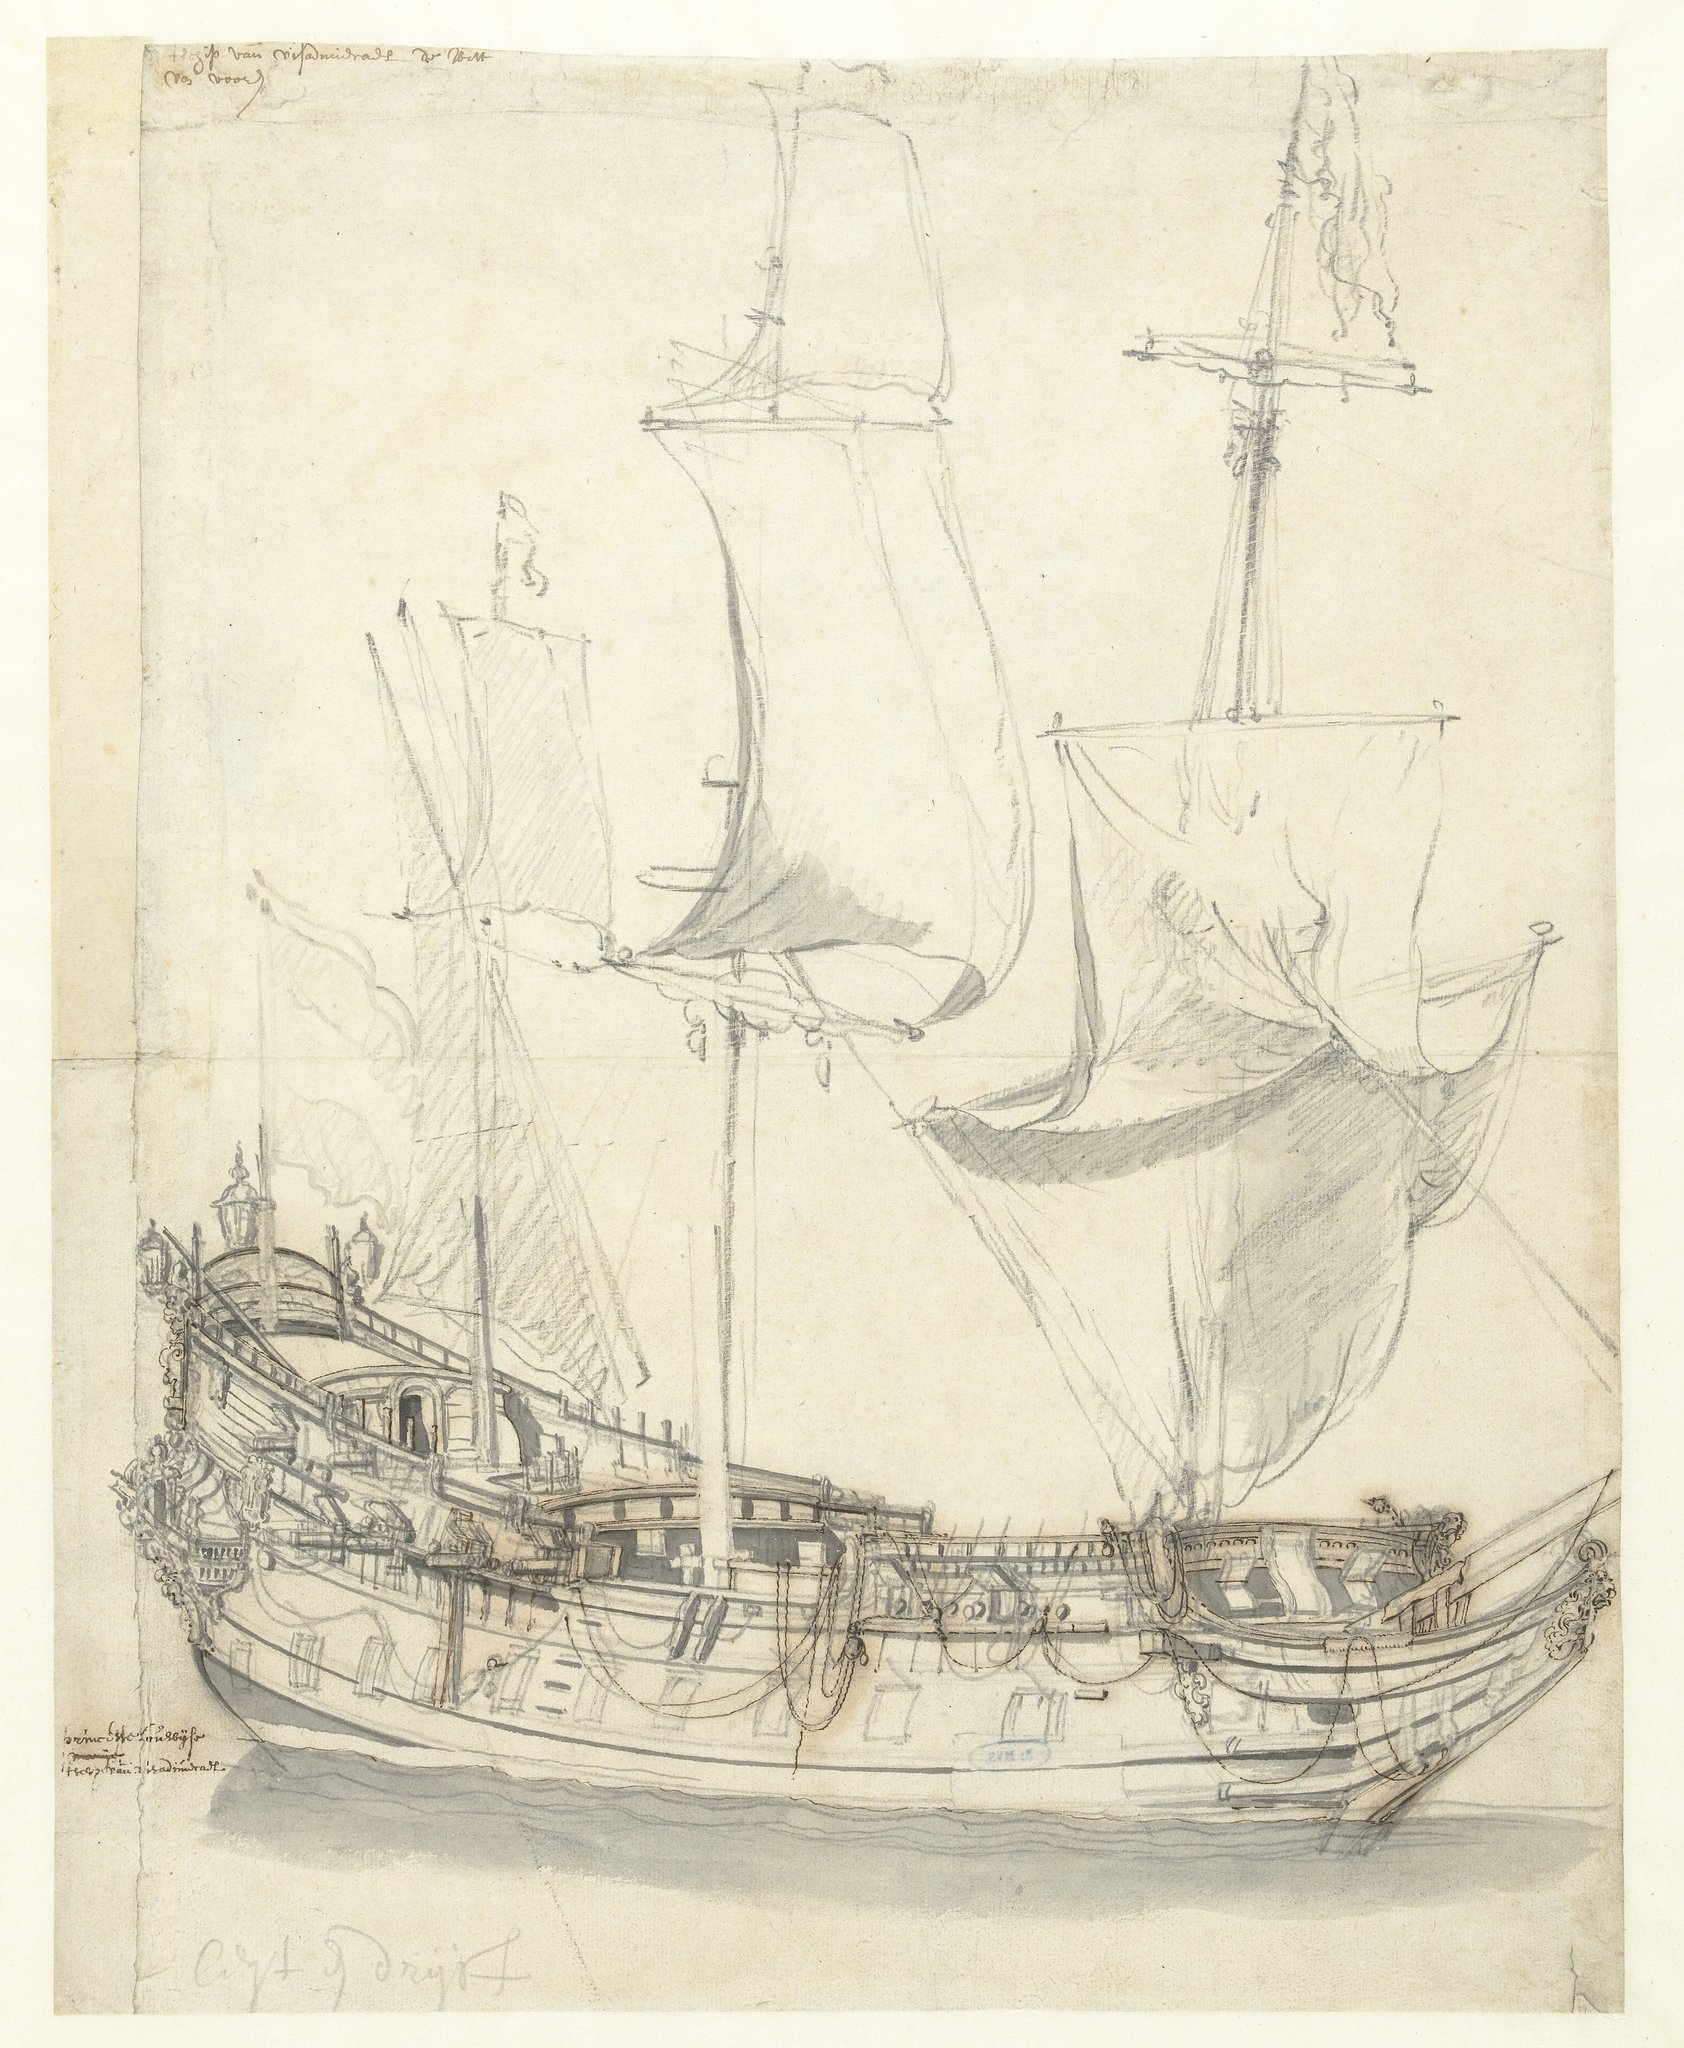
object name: drawing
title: Schip de Princesse Royale van vice-admiraal Witte de With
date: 1621-1693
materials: ink, paper, pencil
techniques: brush, pen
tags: sailing-ship, sailing-boat, names of artefacts and man-made objects (buildings excluded), navy (+ sailing-ships)